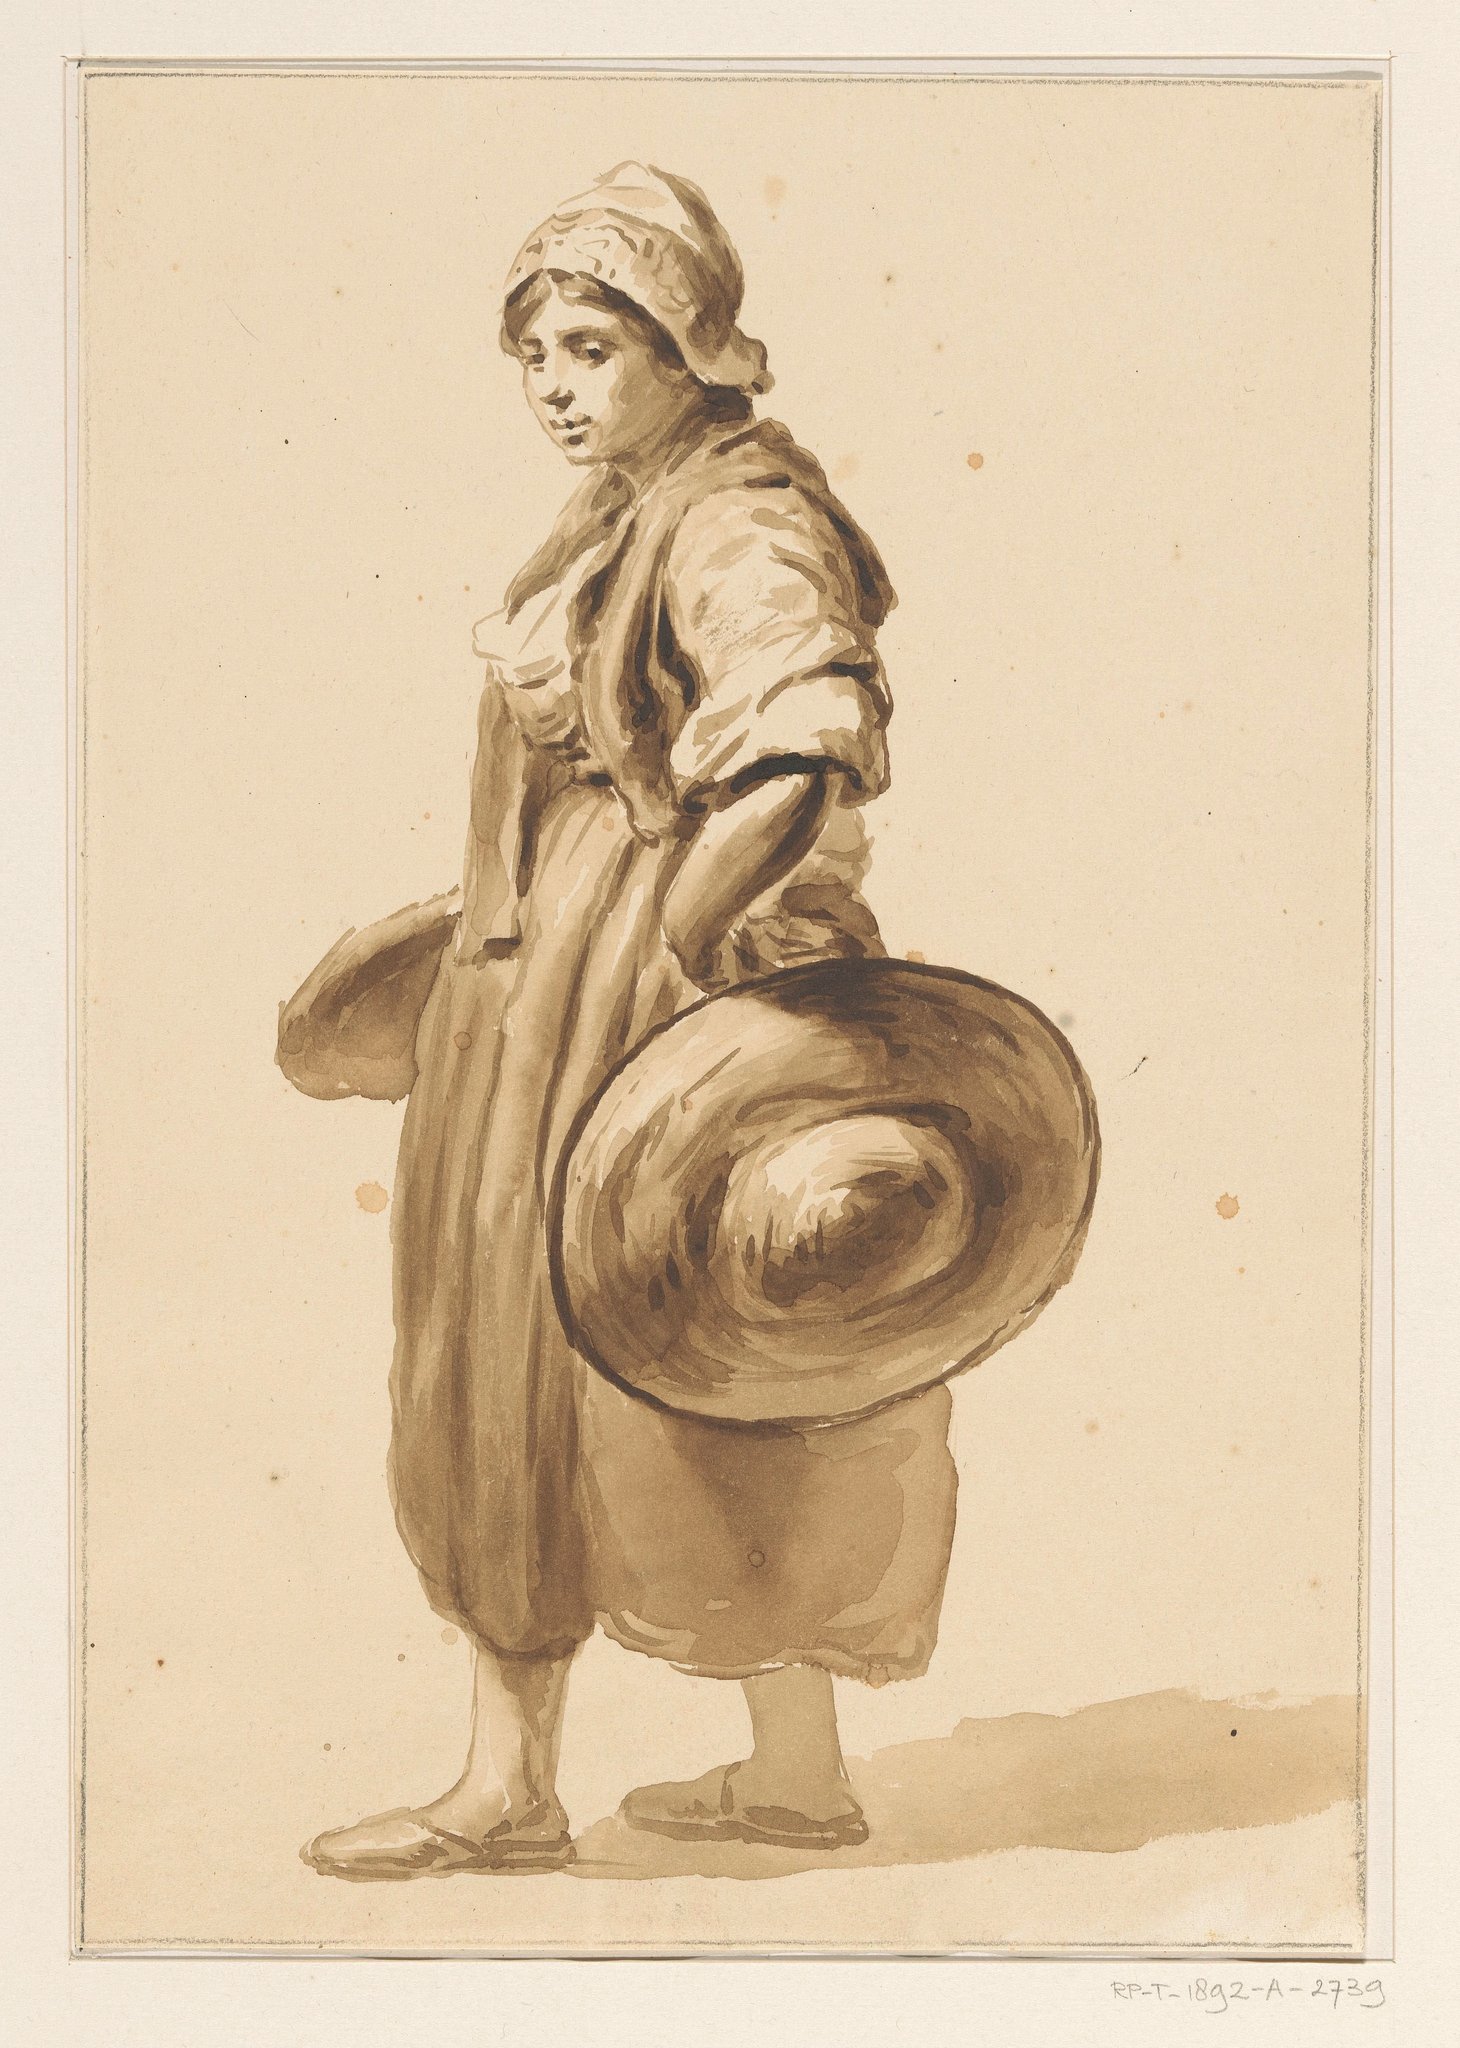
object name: drawing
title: Staand meisje met een hoed in de hand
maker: pieter christoffel wonder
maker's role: draughtsman, painter, print maker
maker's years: 1780-1852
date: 1790-1852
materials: paper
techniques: brush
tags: head-gear: hat (+ women's clothes), girl (child between toddler and youth)